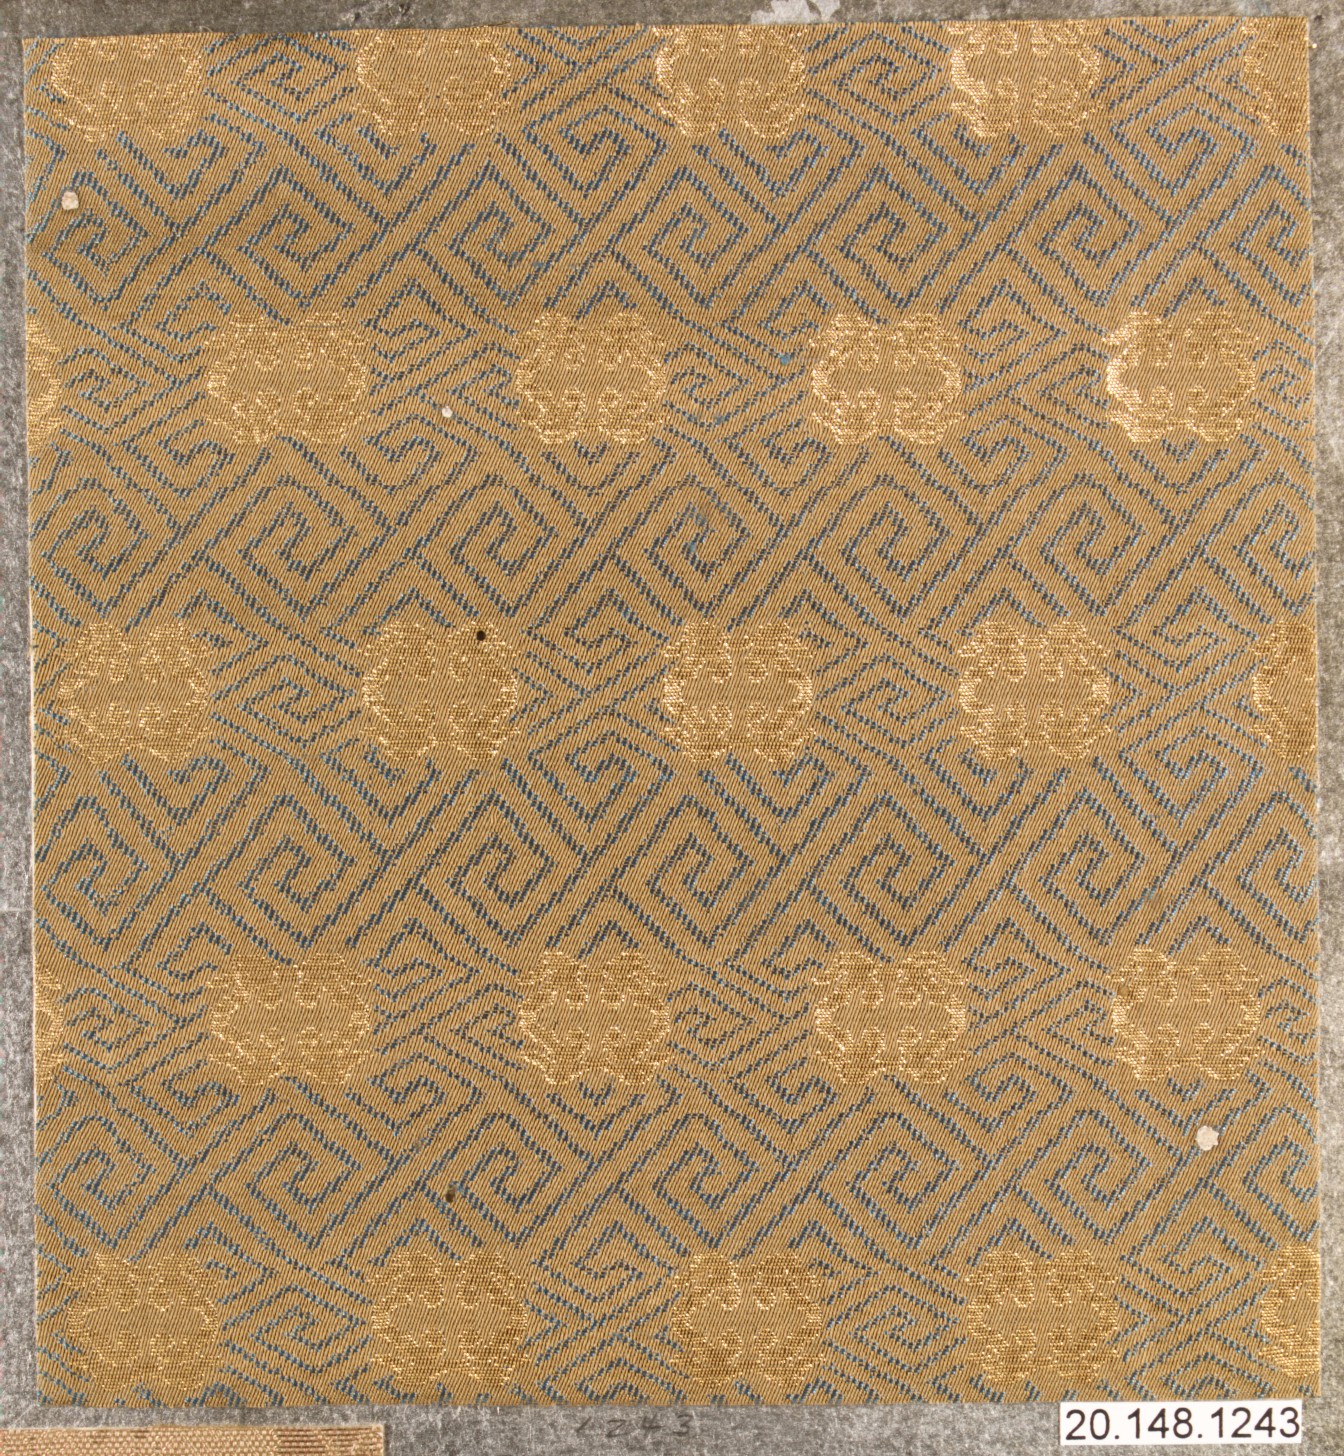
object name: piece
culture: japanese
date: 1801-1900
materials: silk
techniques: compound weave